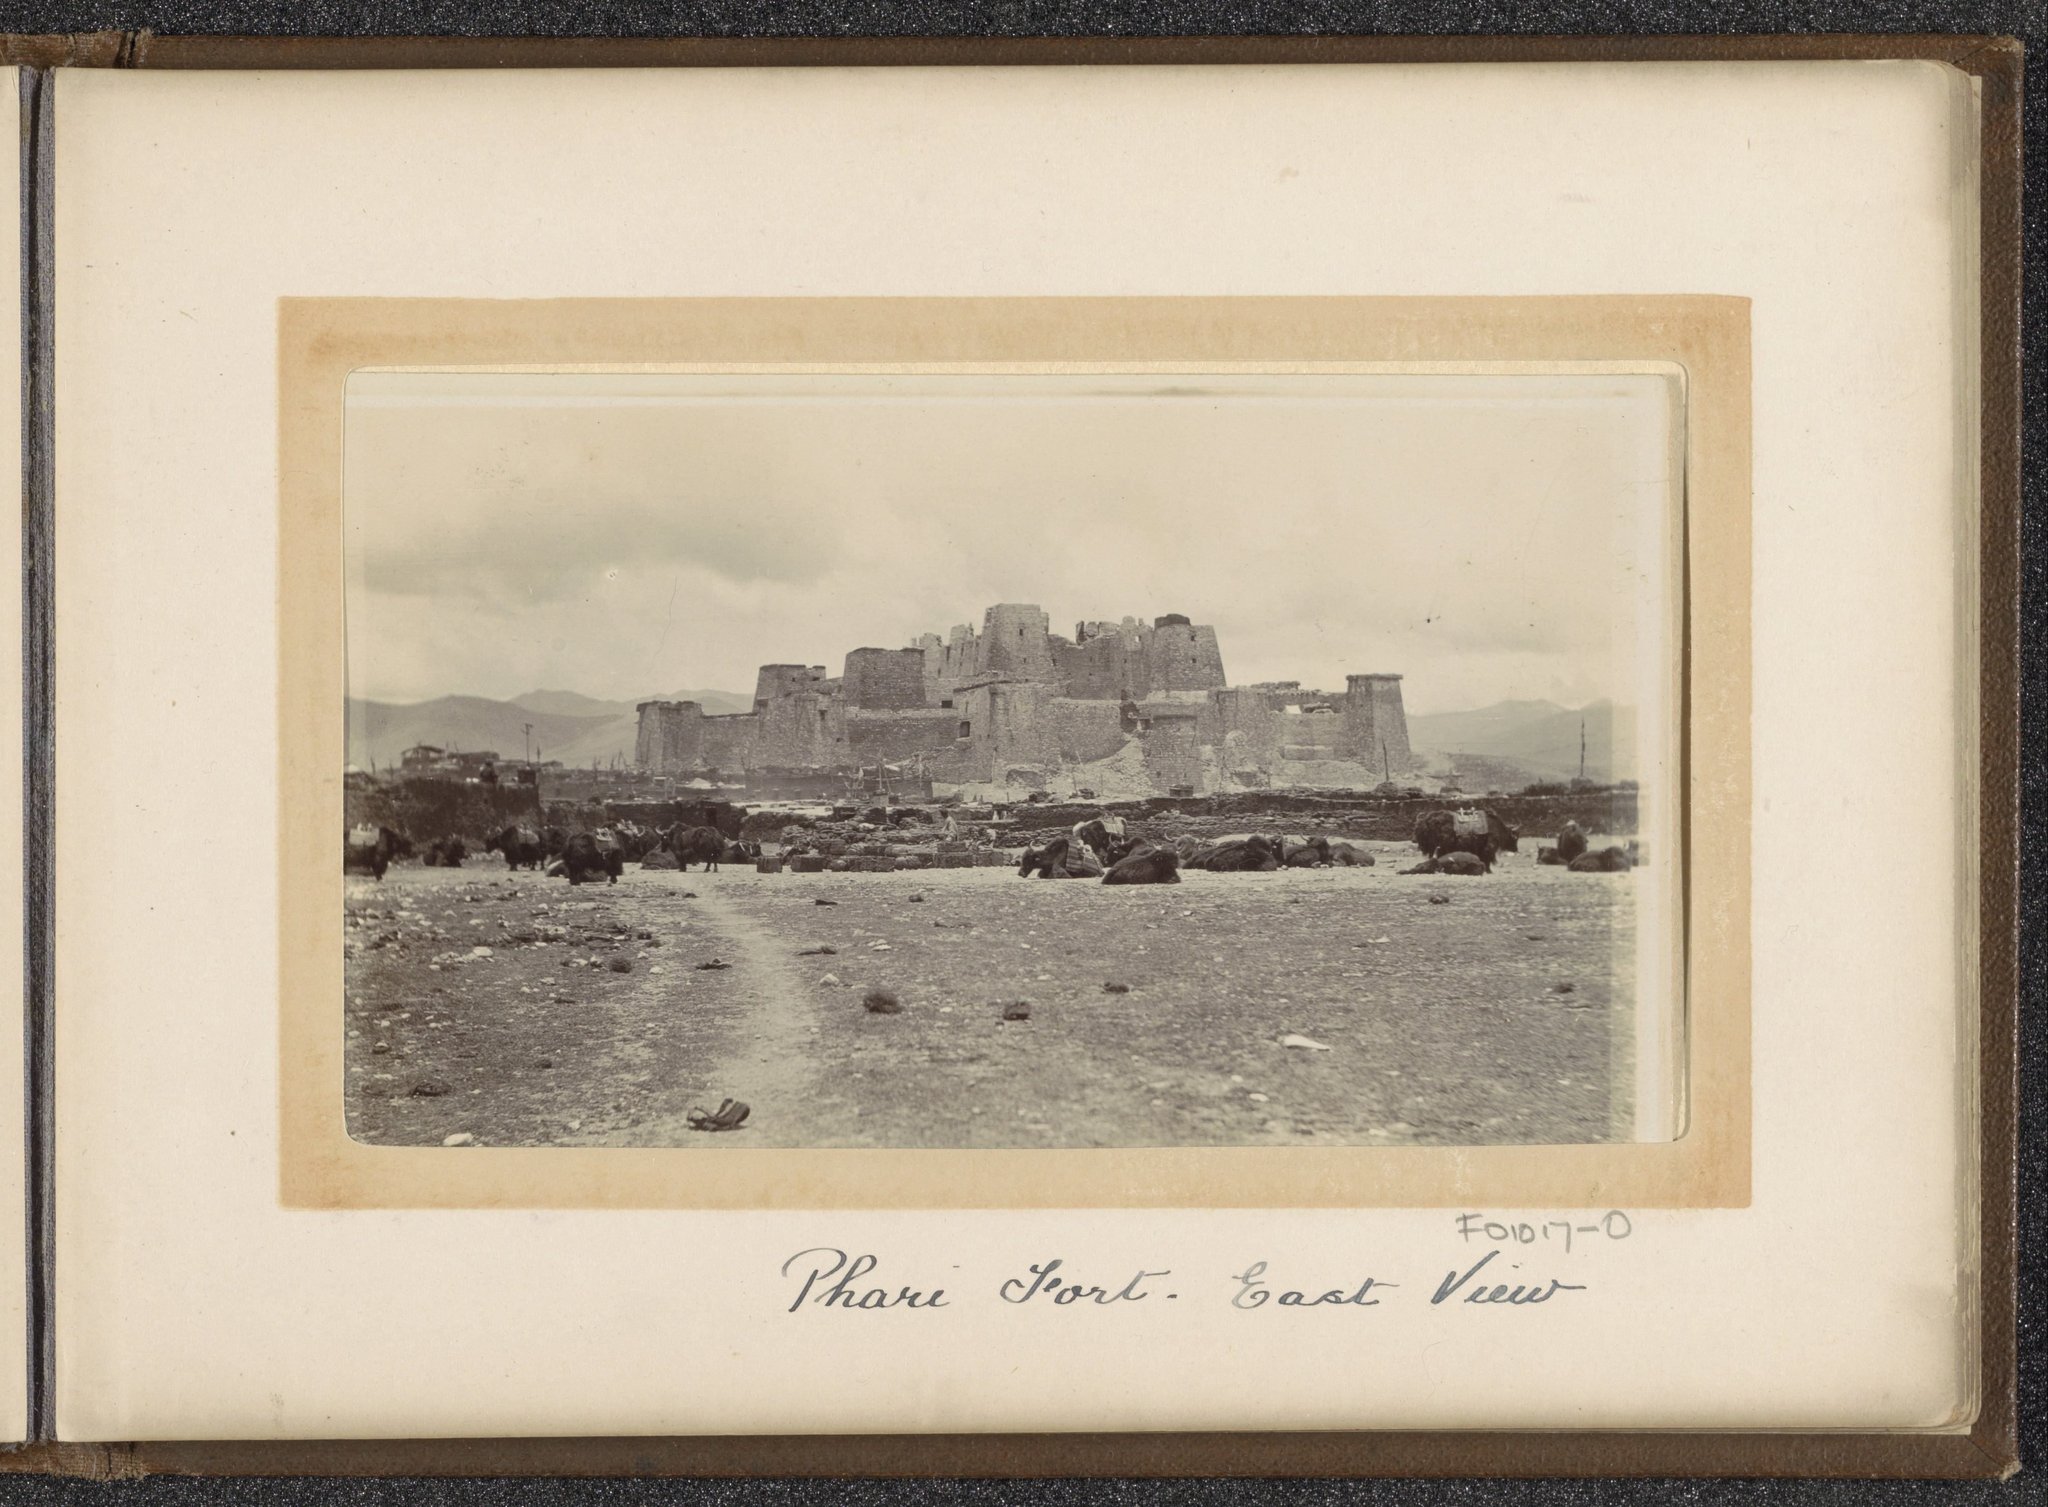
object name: photograph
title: Phari Fort seen from the east with houses and pack animals surrounding it, Tibet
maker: d.t. dalton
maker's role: sergeant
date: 1903-1906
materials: photographic support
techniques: gelatin silver print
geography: phari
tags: pack-animal, fortress, snow, hut, cabin, lodge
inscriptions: title: ‘Phari Fort. East View’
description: Onderdeel van Fotoalbum met 24 foto's van de reis van legertelegrafist D.T. Dalton door Tibet.